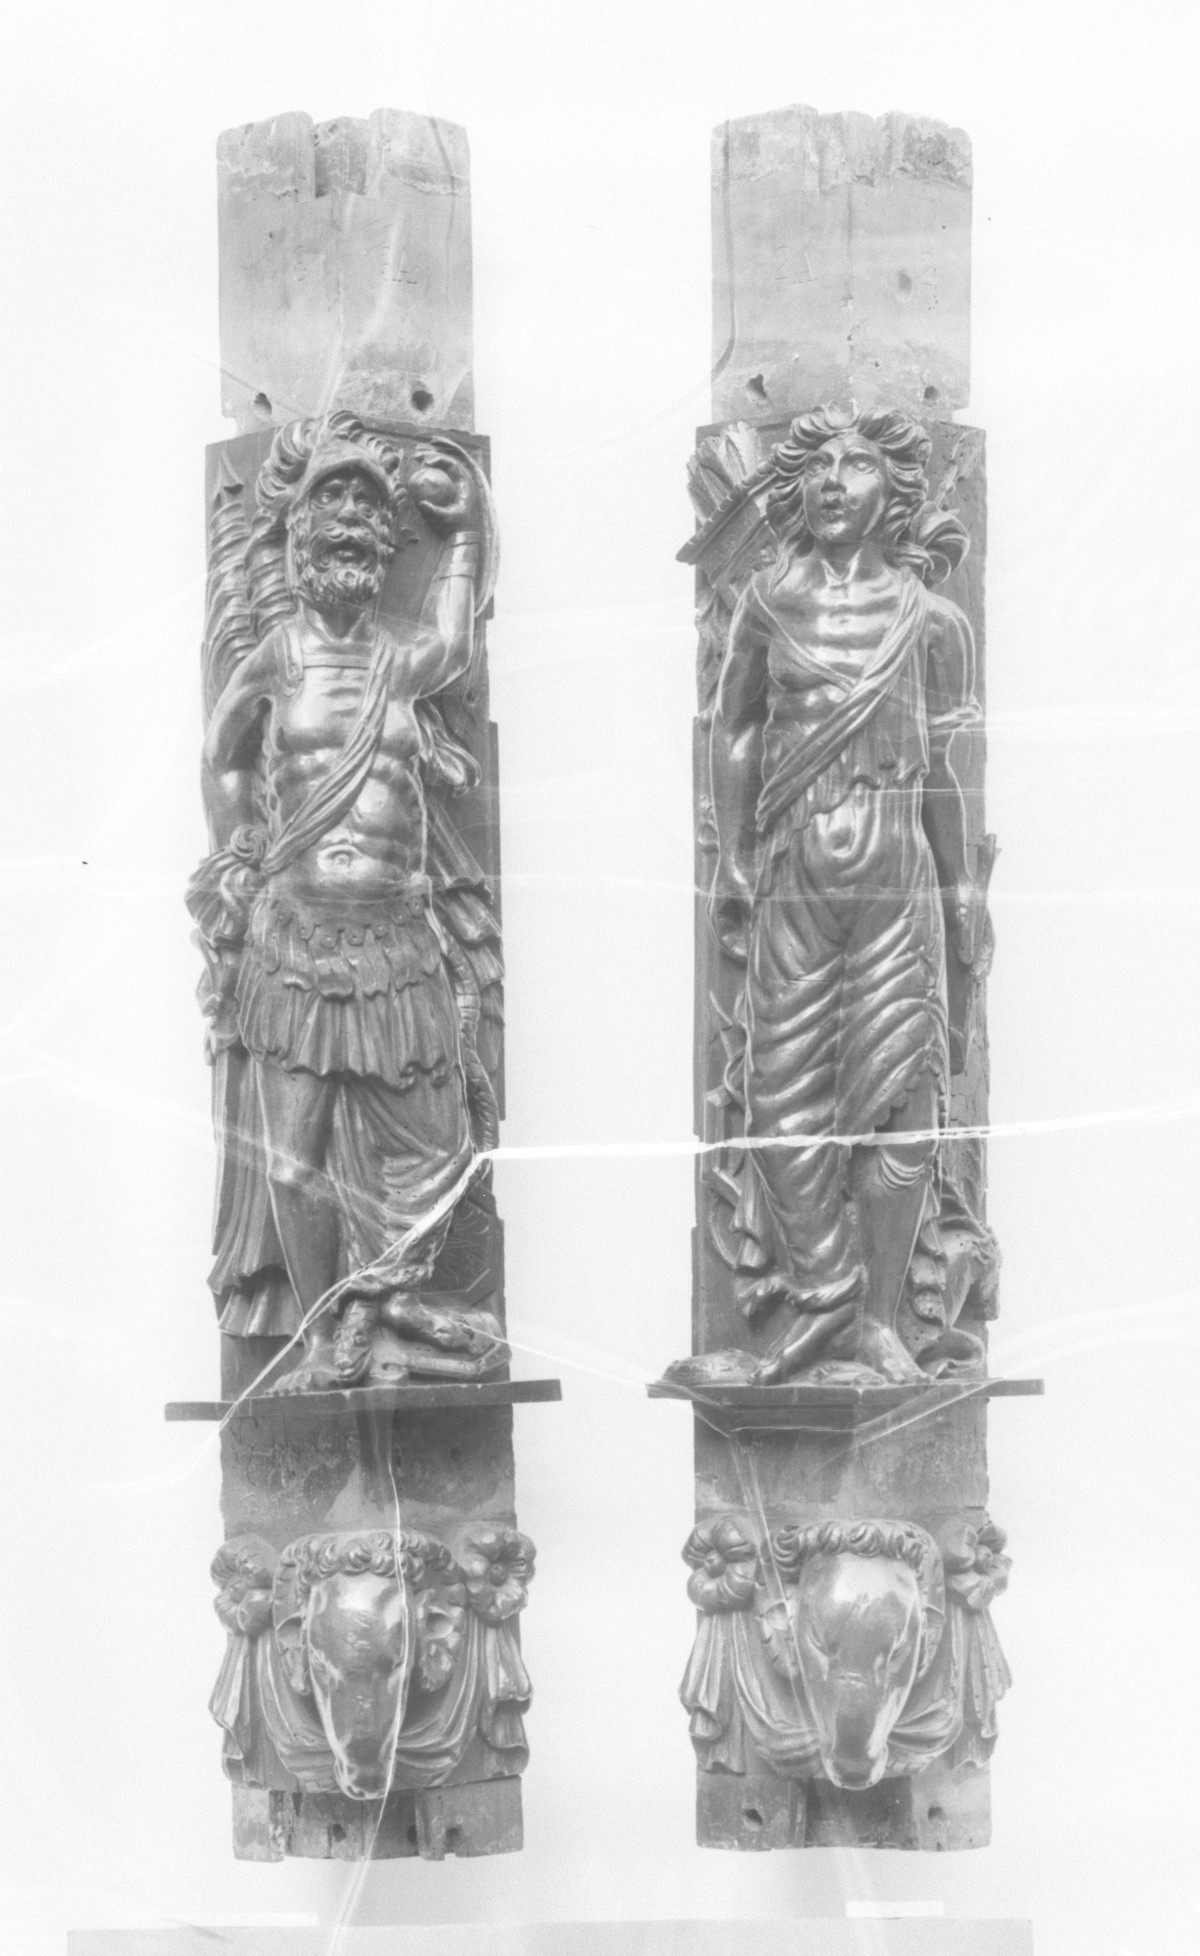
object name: corner post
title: Pair of corner posts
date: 1501-1600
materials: wood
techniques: carving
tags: caryatids,men